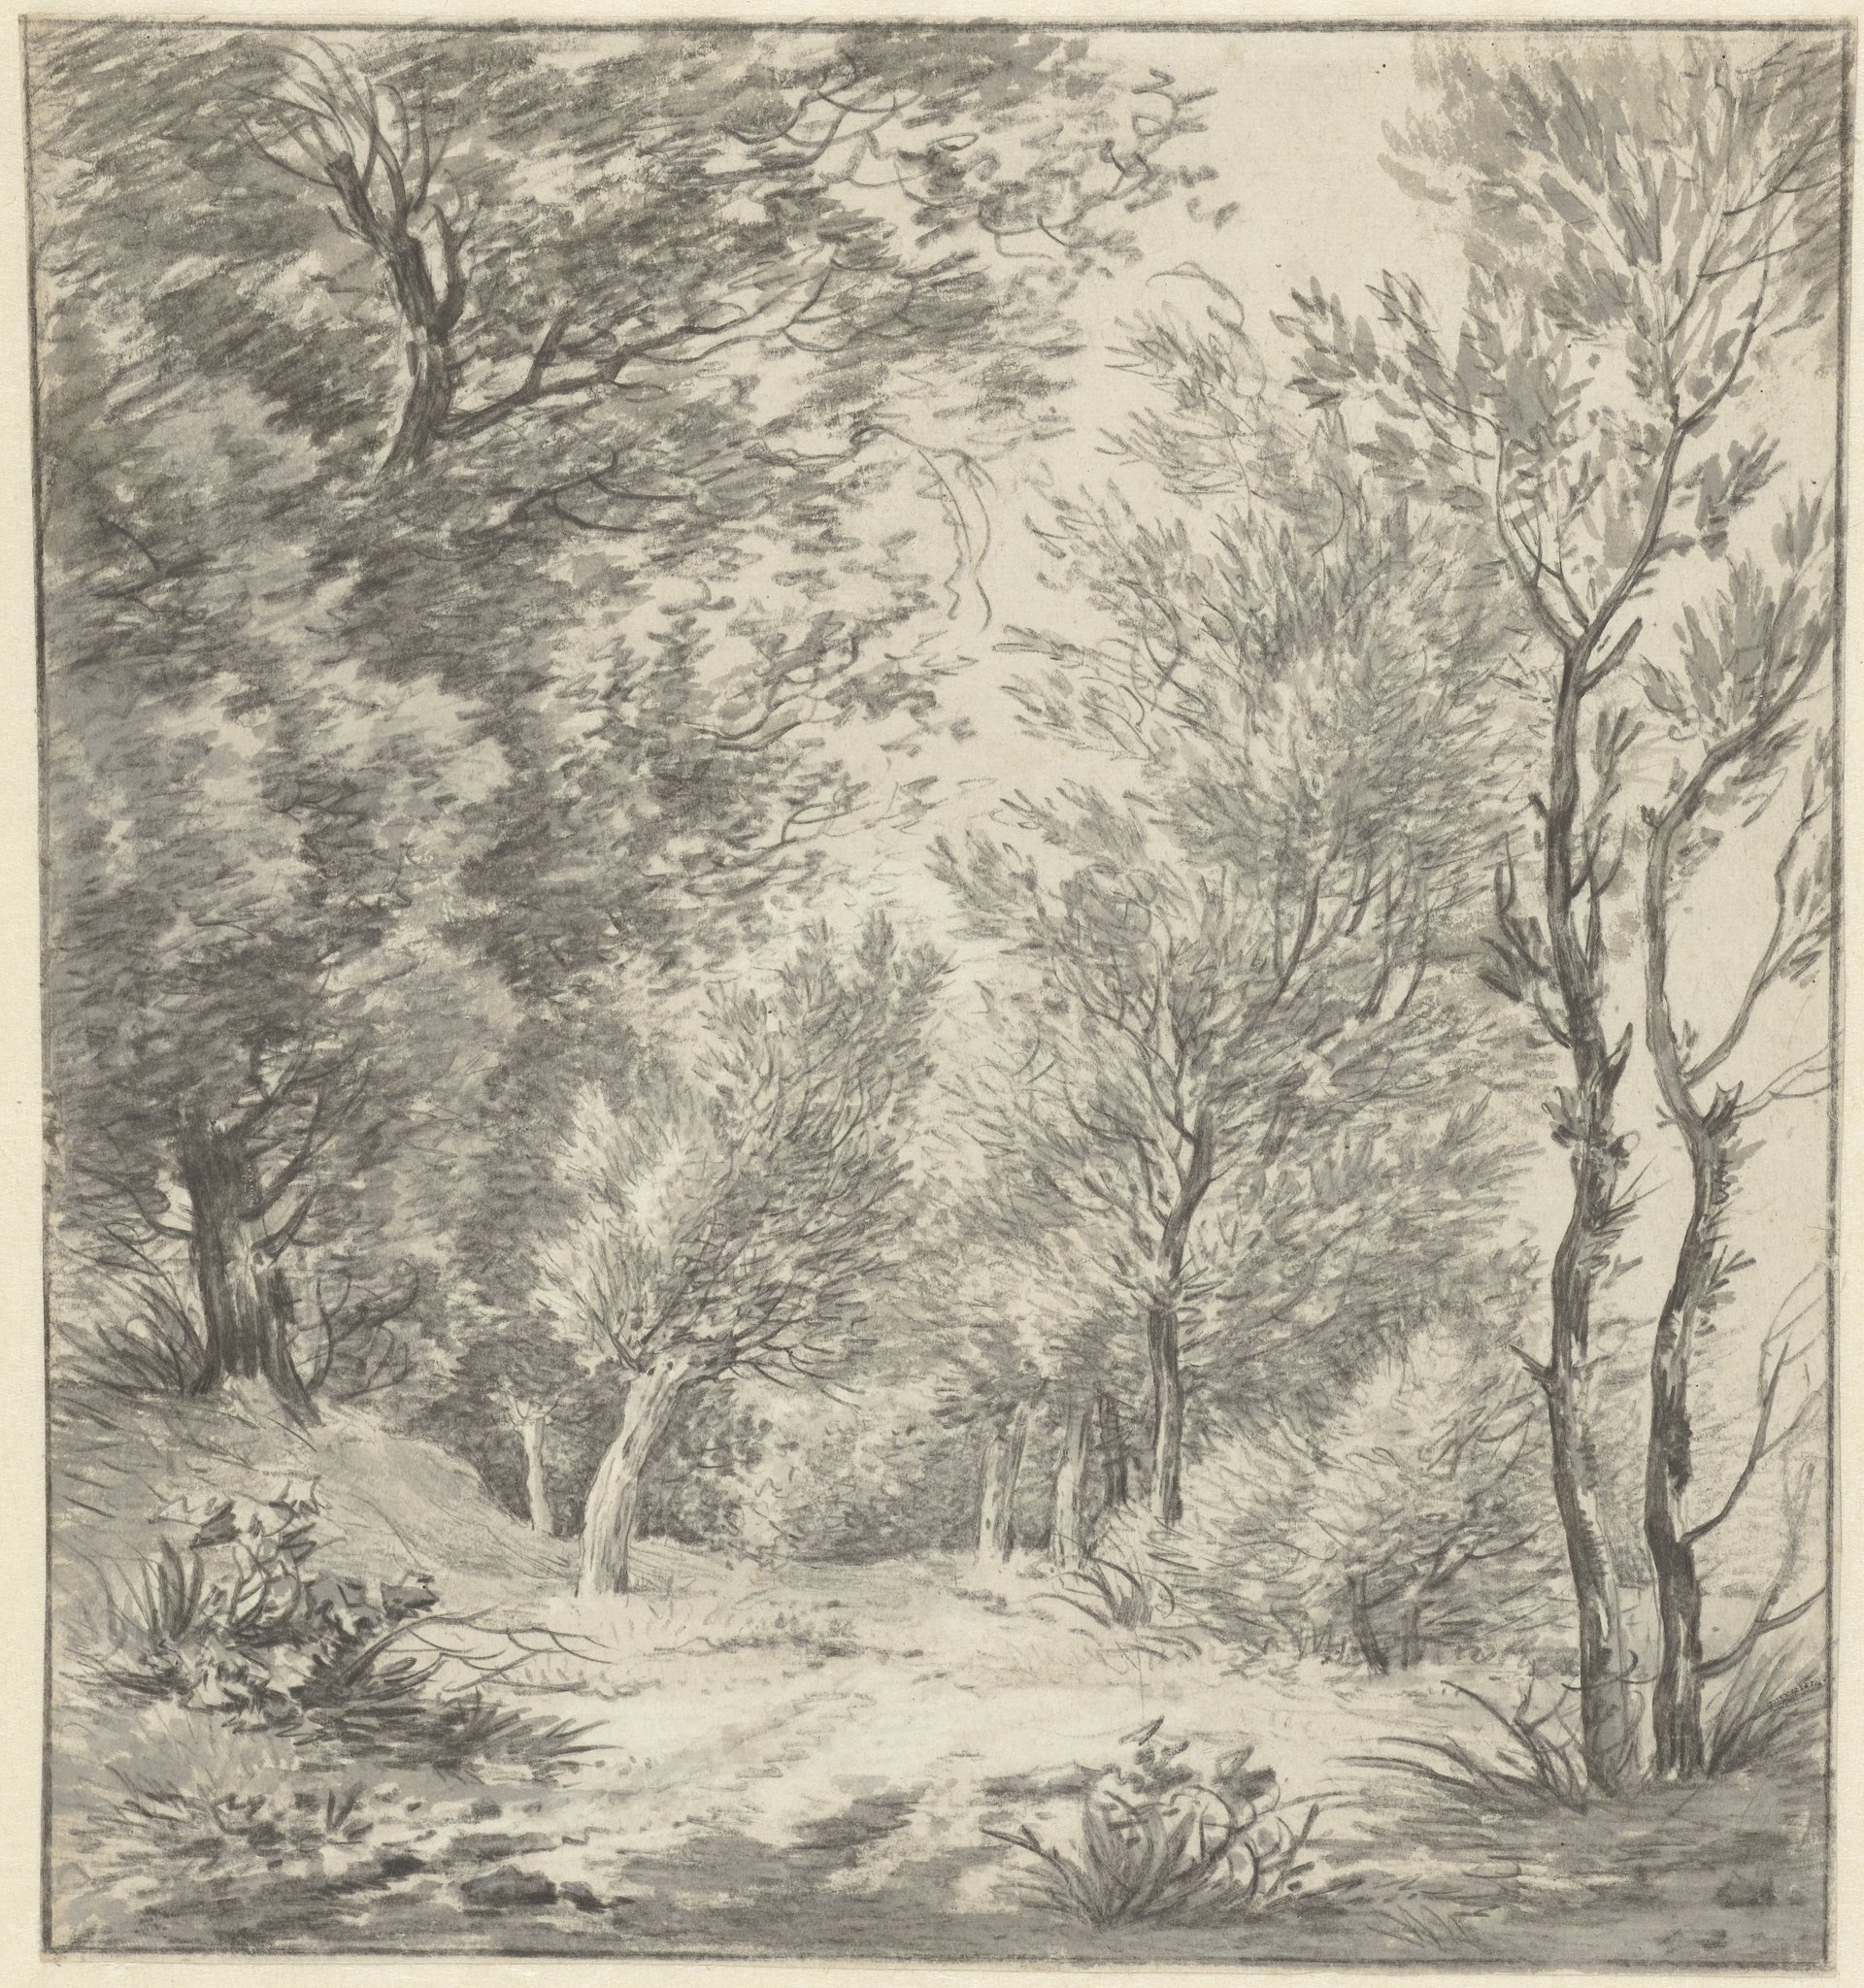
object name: drawing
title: Bomen aan de Amstelveense Weg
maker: hermanus fock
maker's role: conservator, draughtsman, painter, print maker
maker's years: 1766-1822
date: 1776-1822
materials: chalk, paper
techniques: brush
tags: forest, wood, amsterdam